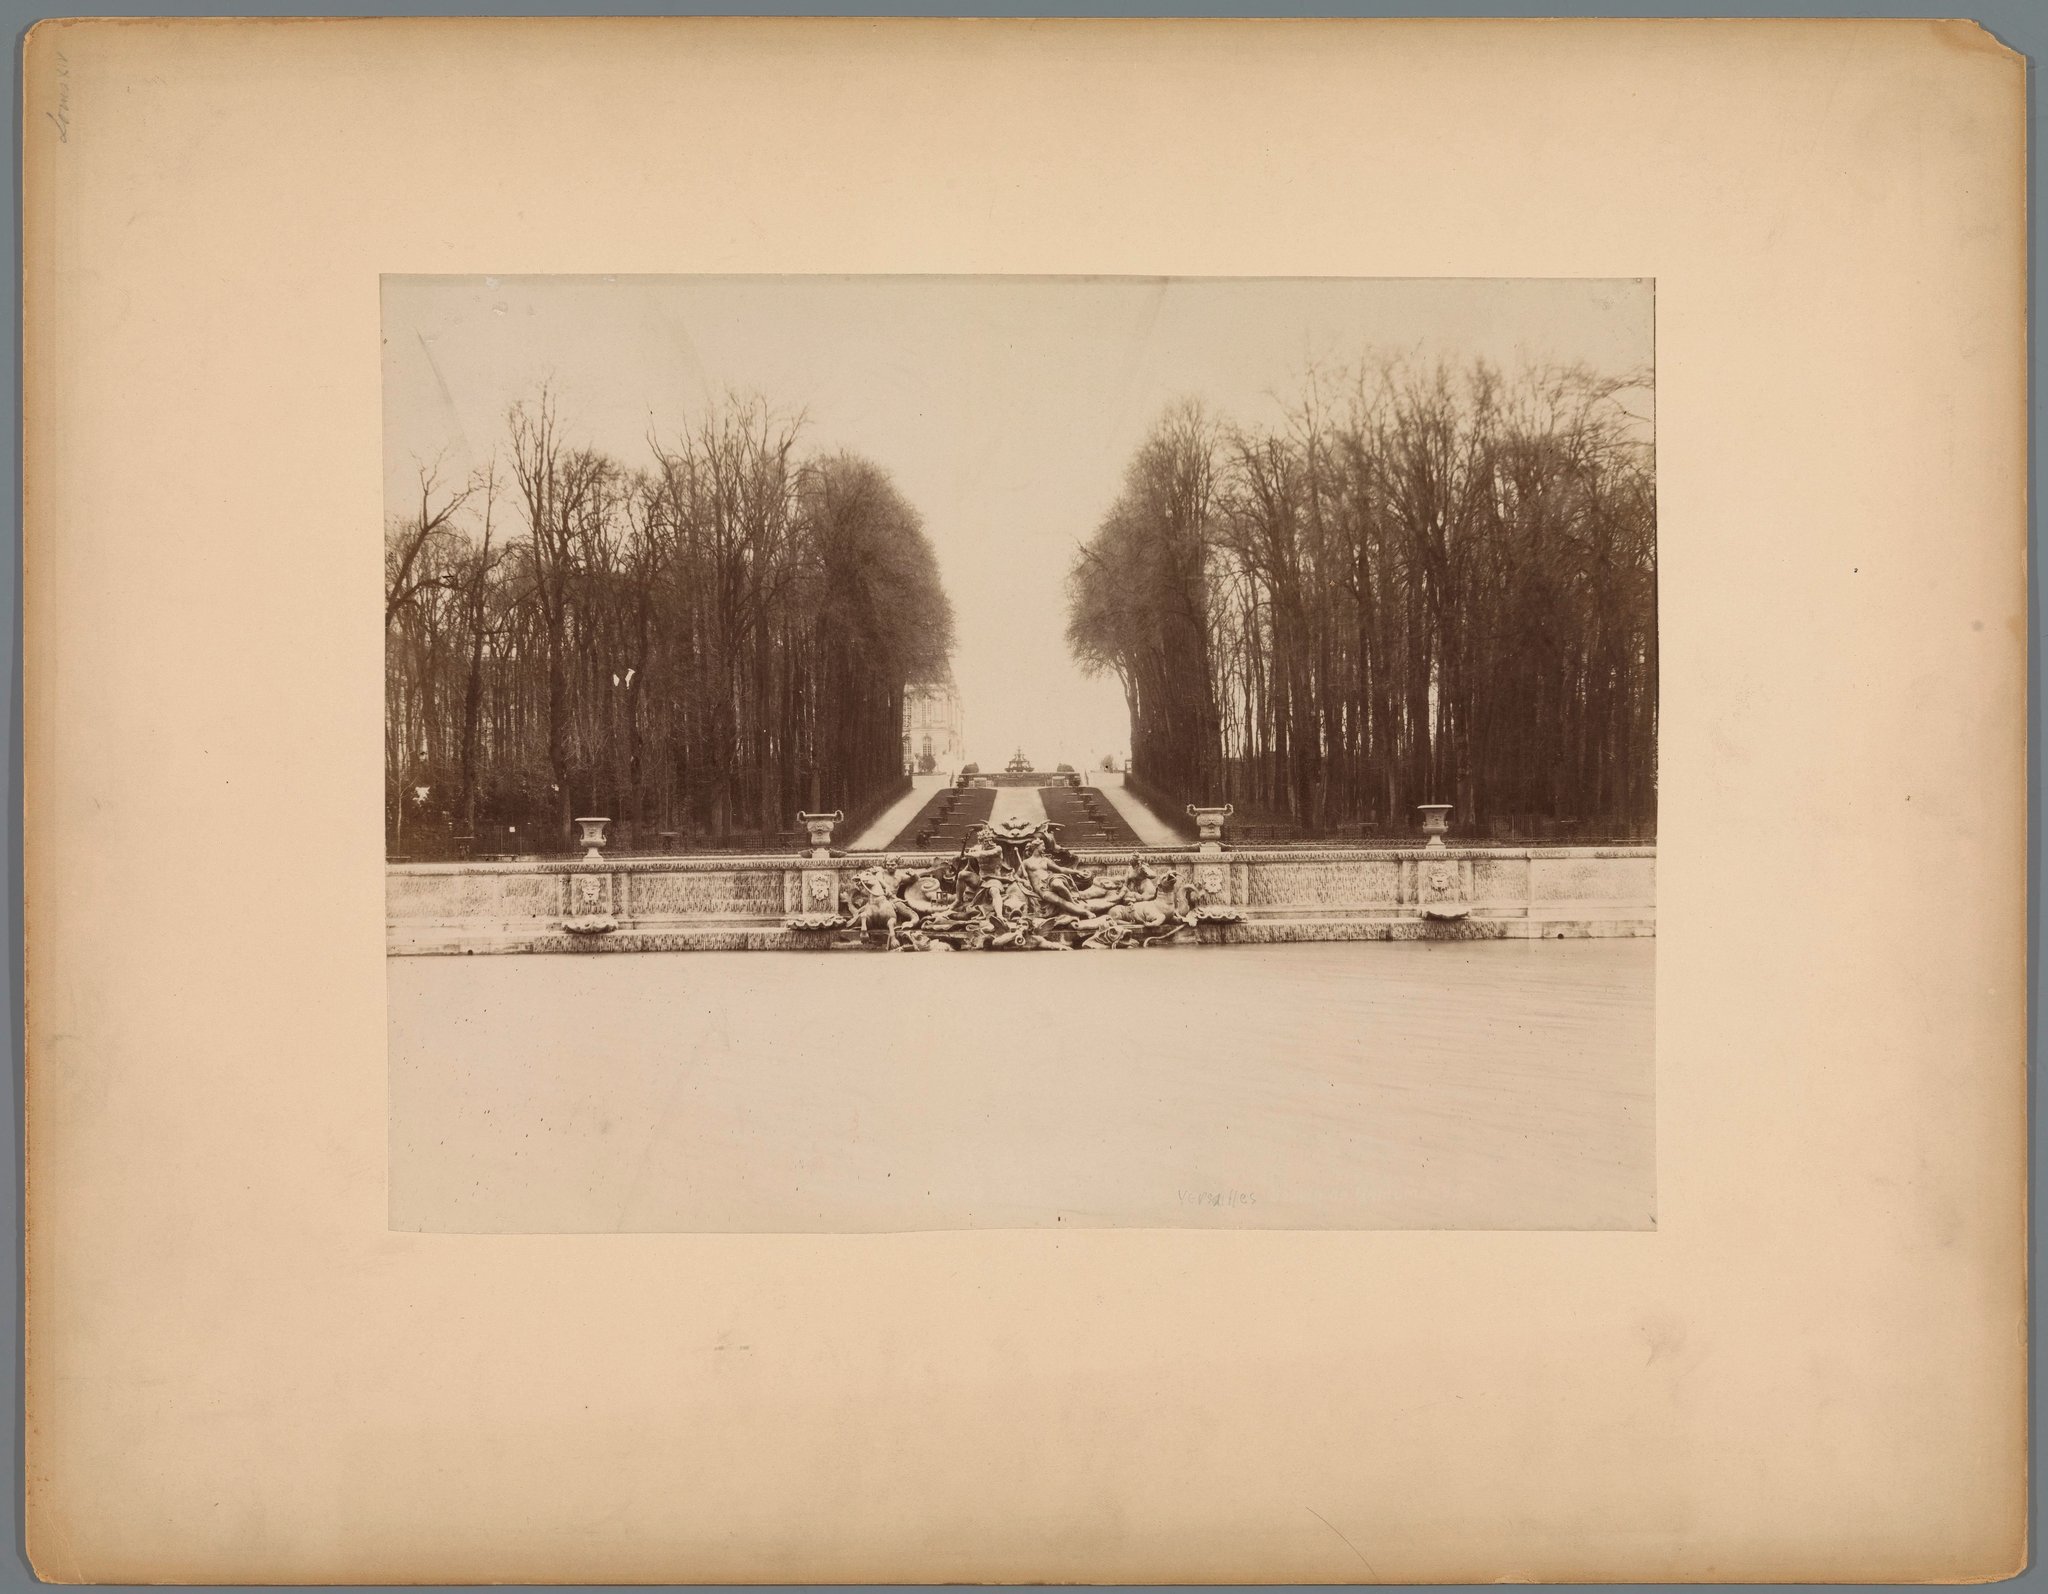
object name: photograph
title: Fontein van Neptunus in de tuin van het kasteel van Versailles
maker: Anonymous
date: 1875-1900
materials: cardboard, photographic support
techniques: albumen print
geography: versailles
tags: garden fountain, public gardens, park, neptune as lord of the sea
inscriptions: collector's mark: Lugt 3937